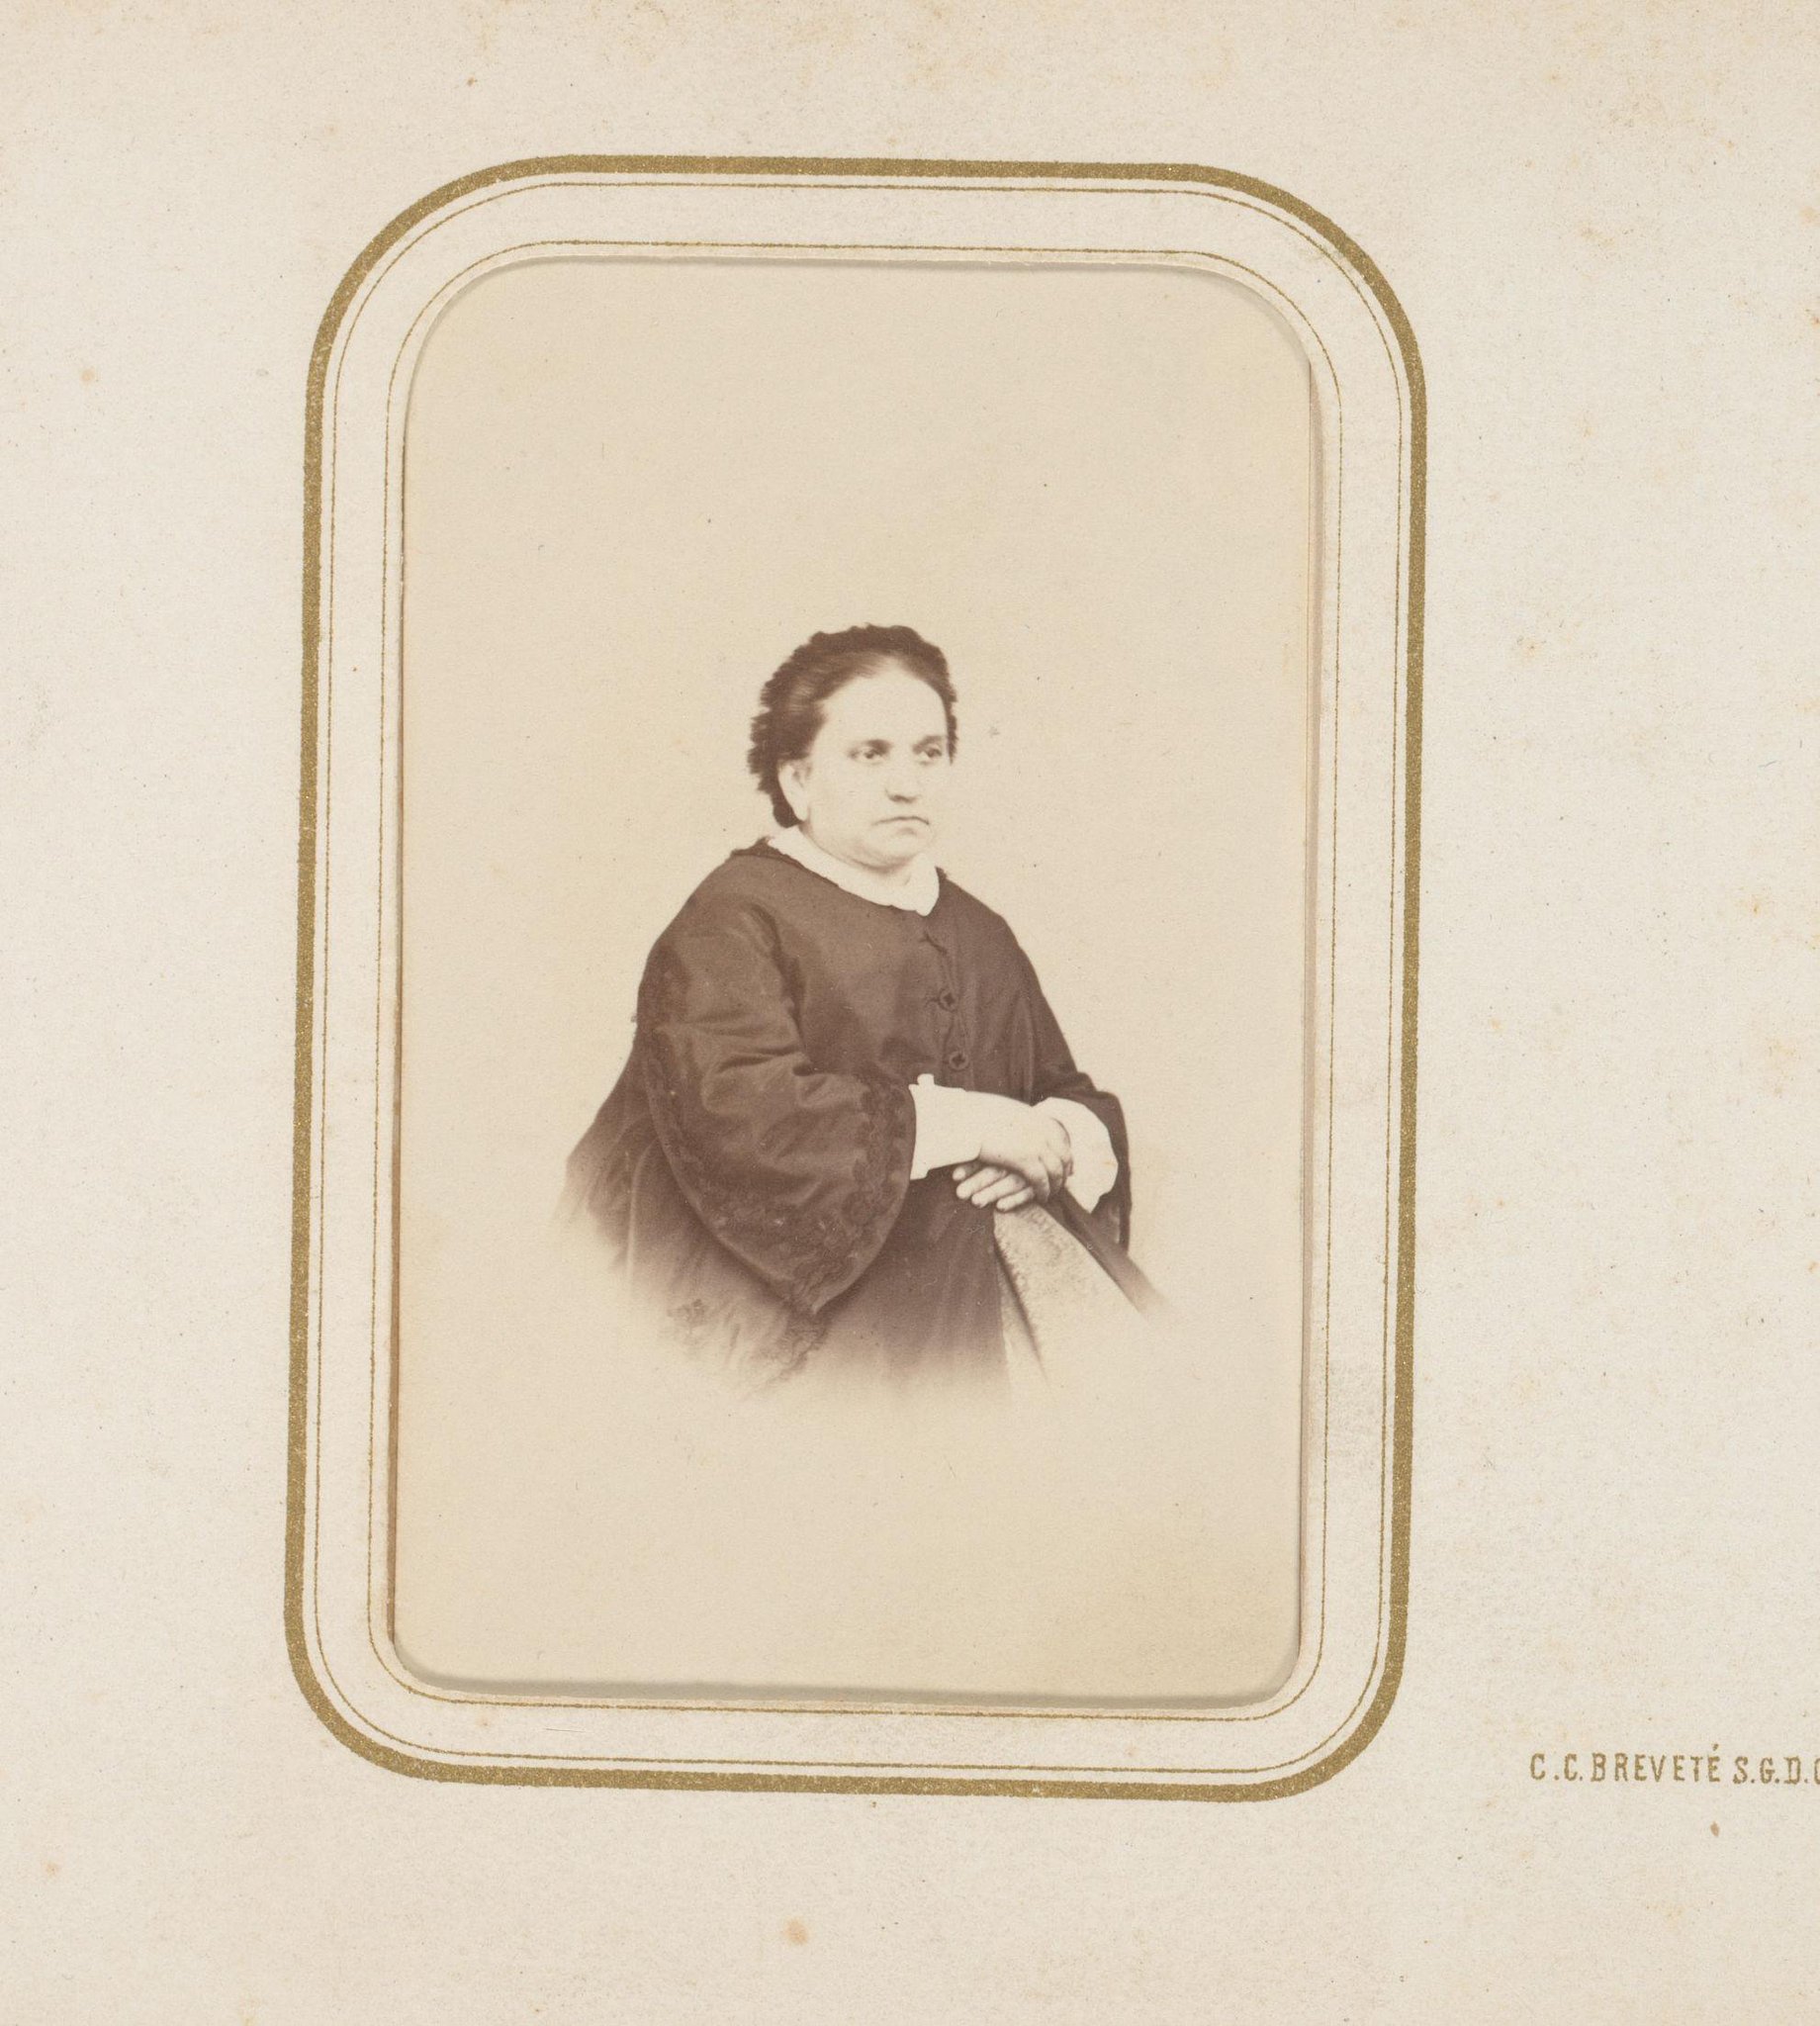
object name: photograph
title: Portret van een vrouw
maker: Anonymous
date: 1860-1900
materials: cardboard, photographic support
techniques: albumen print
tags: adult woman, historical persons